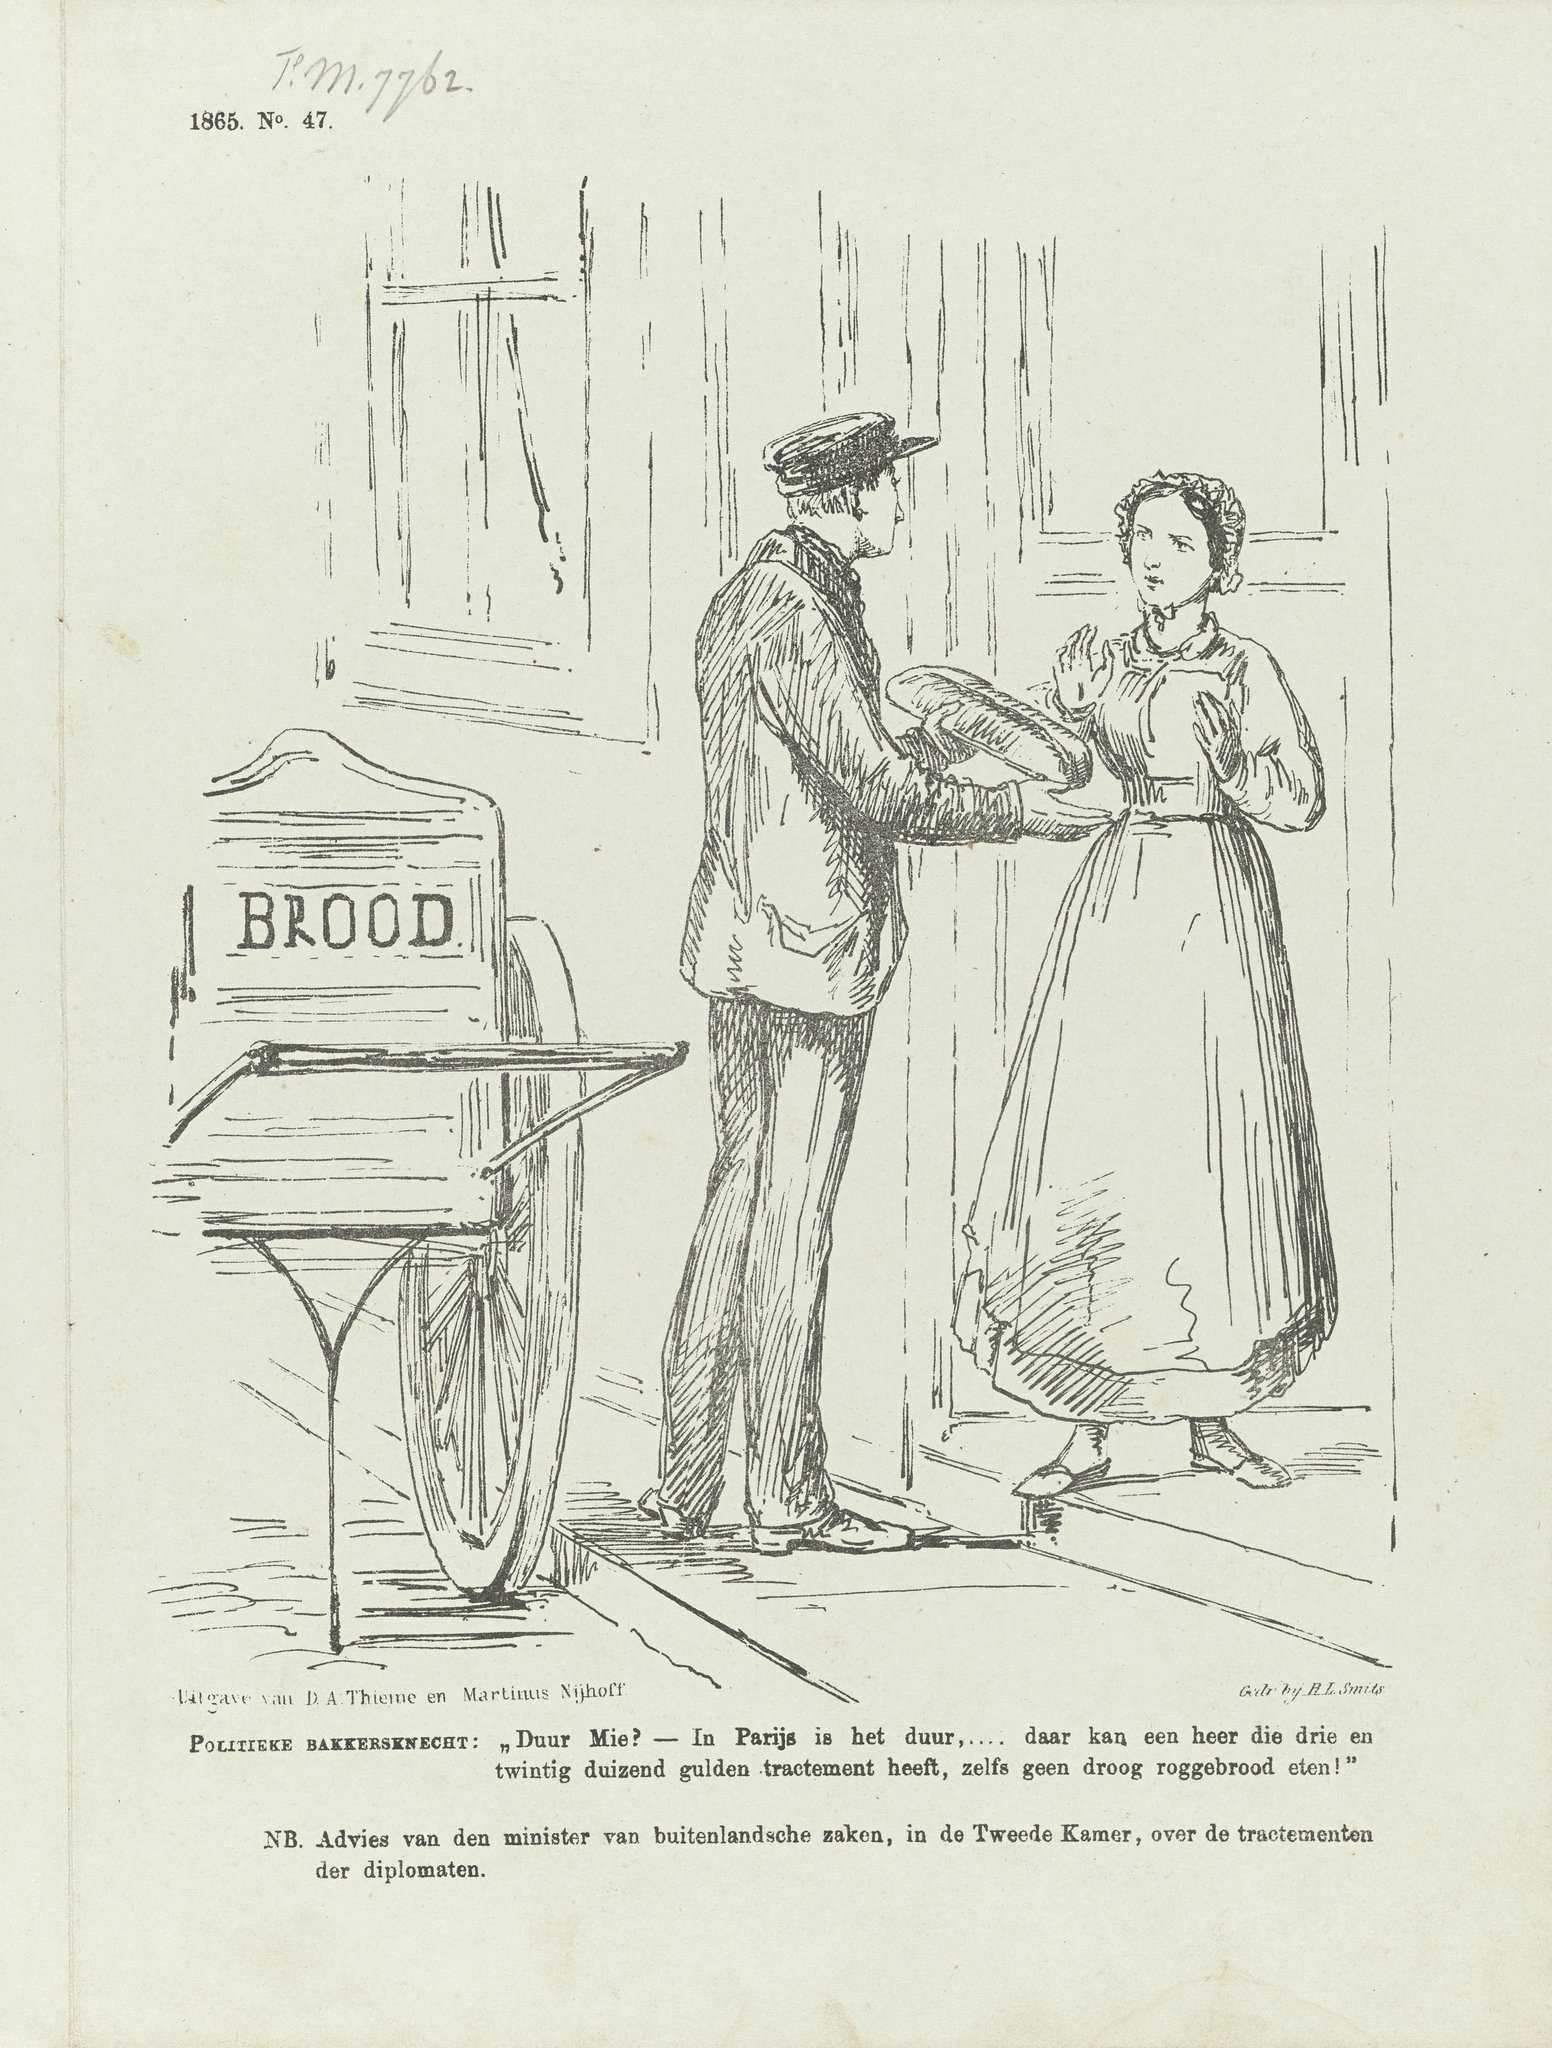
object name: cartoon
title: Spotprent over de tractementen van de diplomaten, 1865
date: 1865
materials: paper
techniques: lithograph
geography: netherlands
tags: baker, kitchen-maid, kitchen servant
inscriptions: collector's mark: Lugt 2228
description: Spotprent over het advies van de Minister van Buitenlandse Zaken in de Tweede Kamer over de tractementen van de diplomaten. Een bakkersknecht bezorgt een brood bij een dienstmeid. Plaat verschenen bij het weekblad De Nederlandsche Spectator, nr. 47, 25 november 1865.